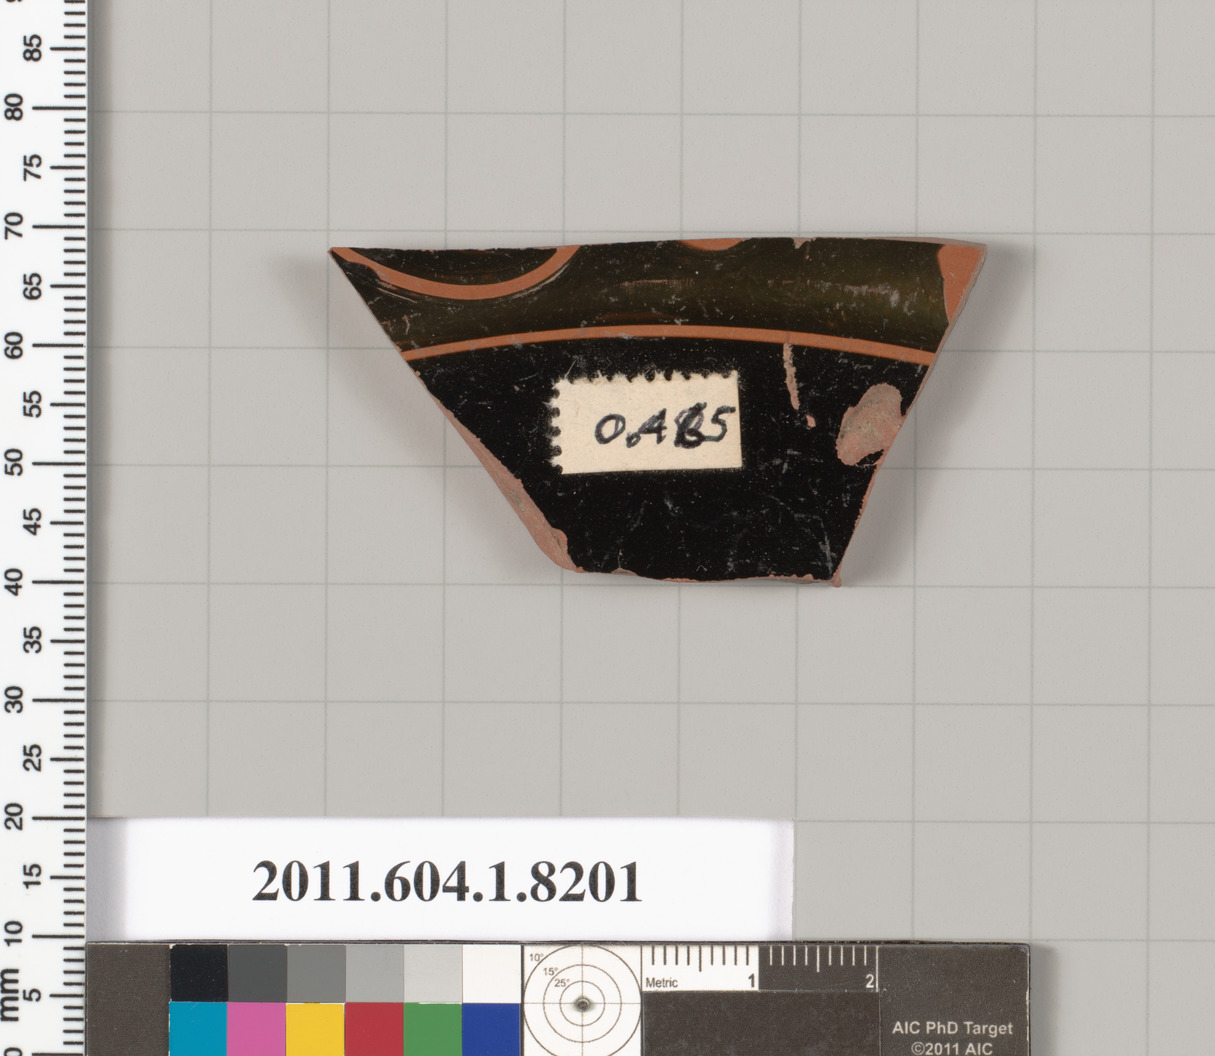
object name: kylix fragment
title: Terracotta fragment of a kylix (drinking cup)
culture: greek, attic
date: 520-510 BCE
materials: terracotta